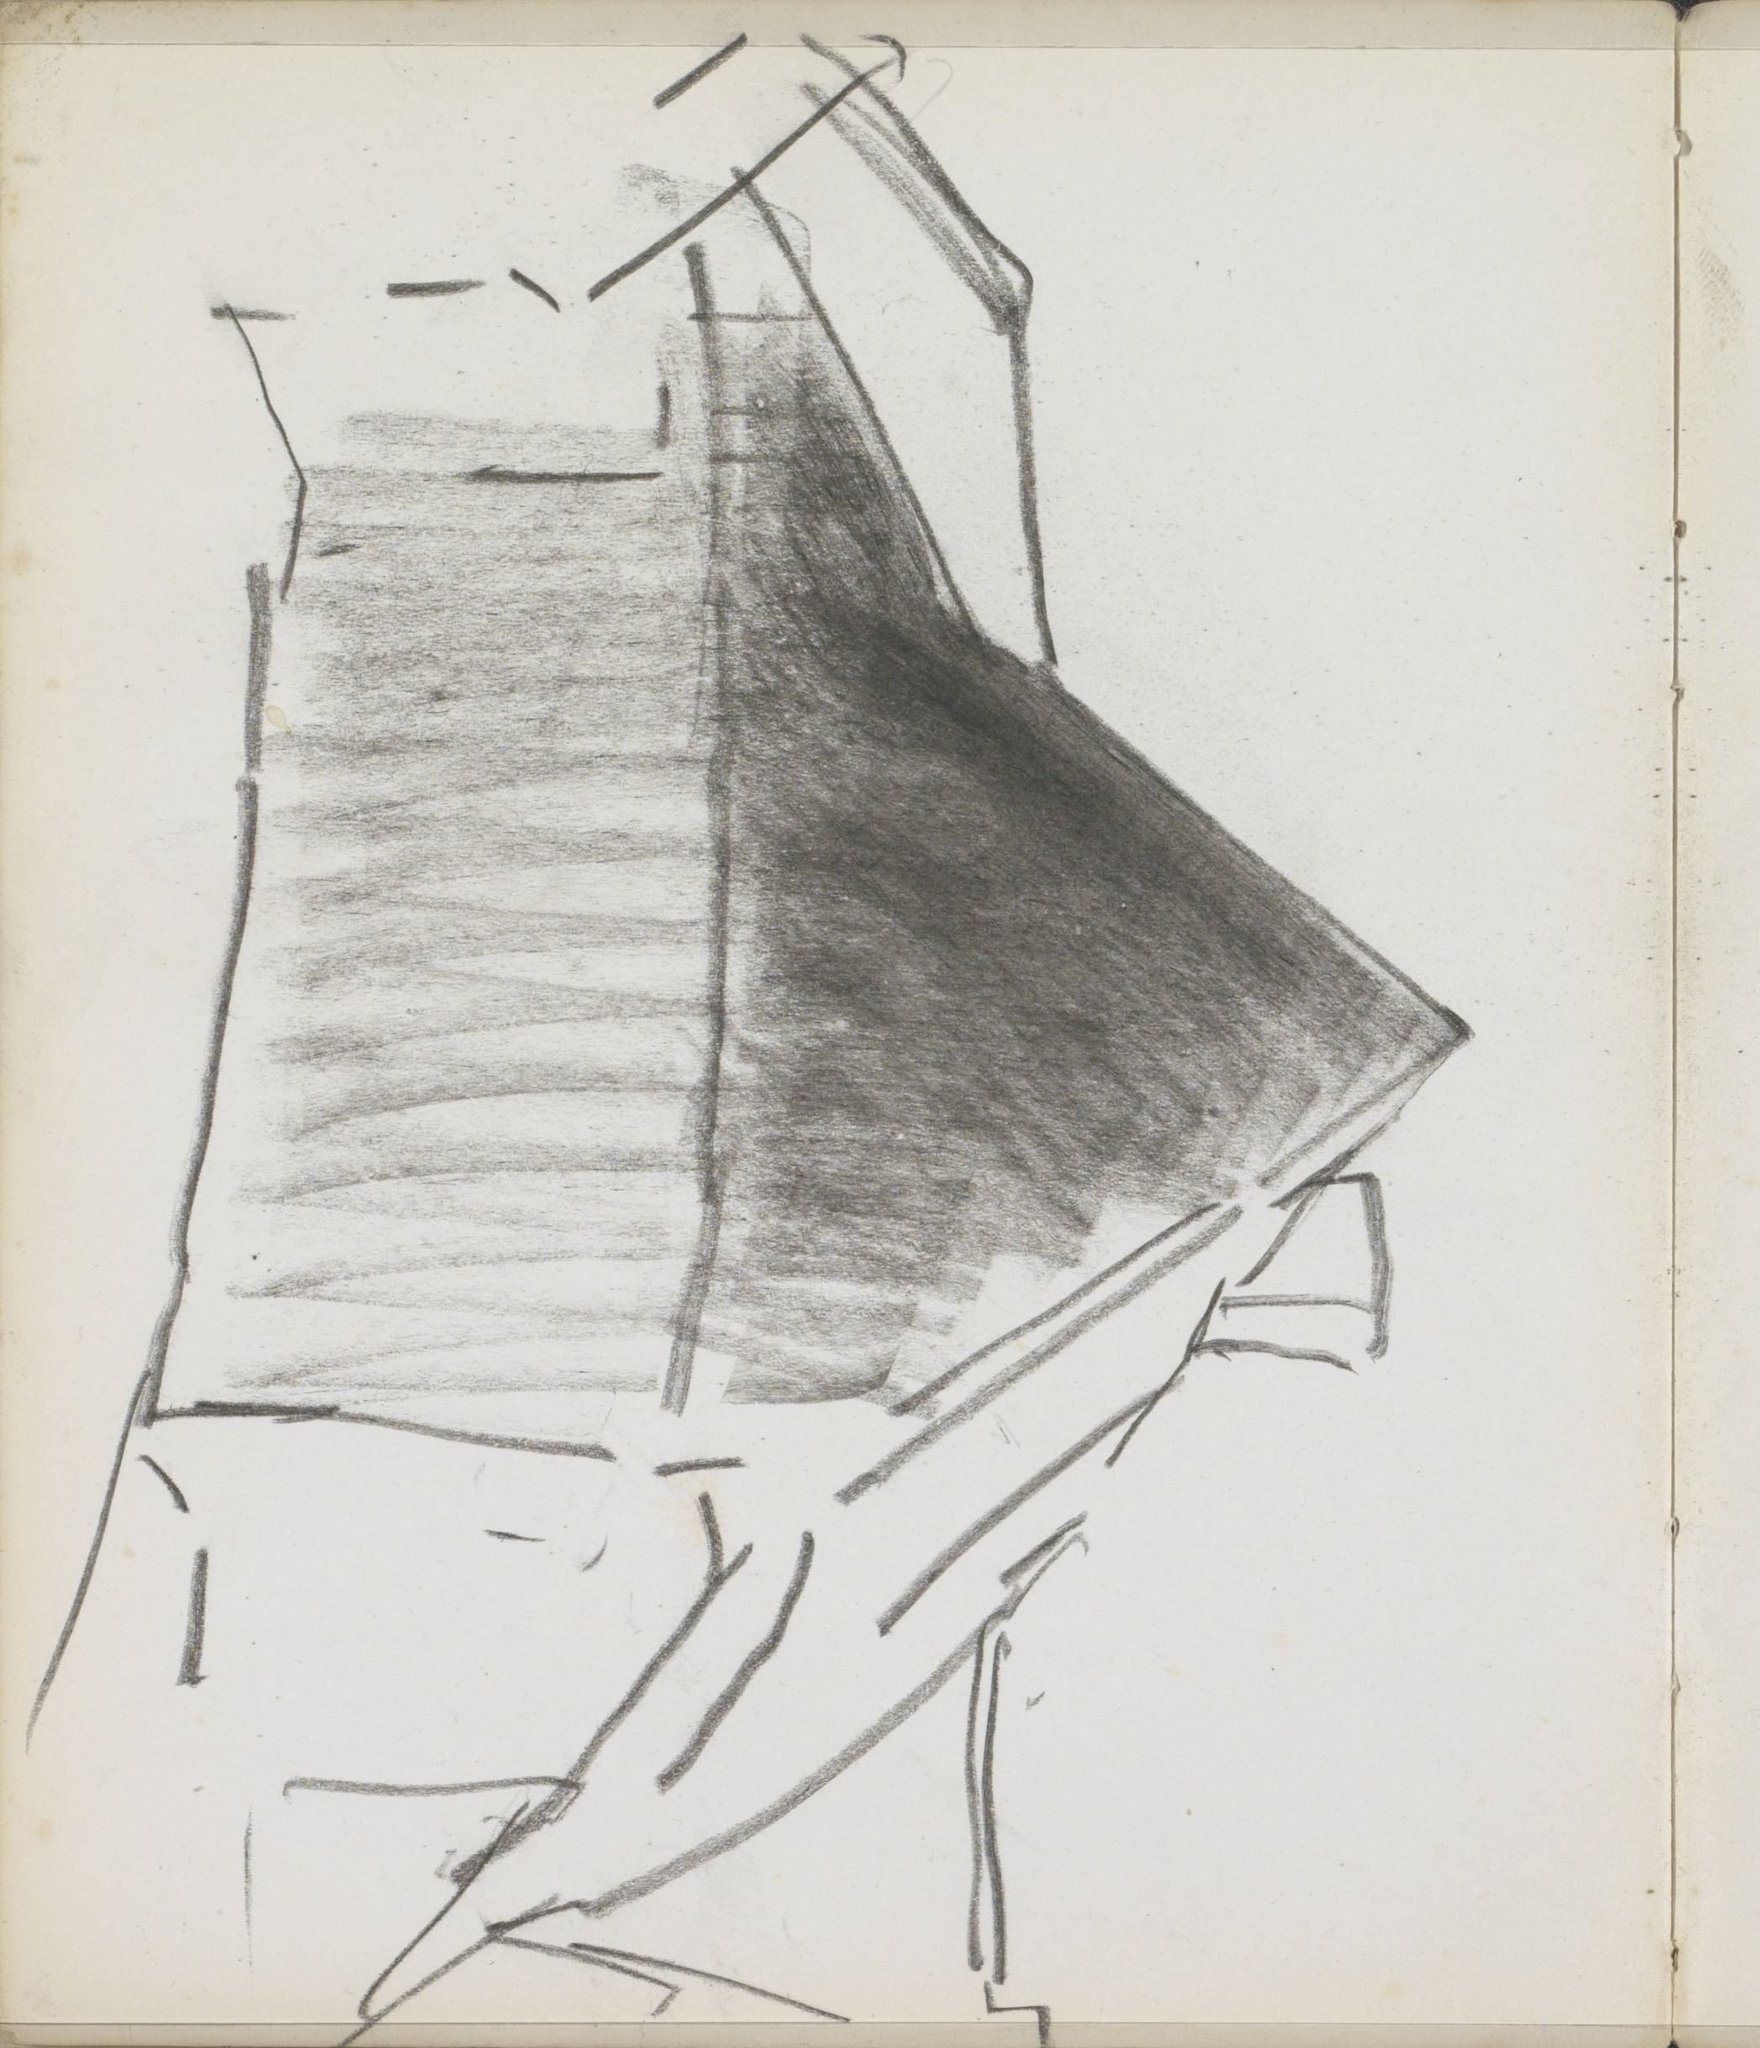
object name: sketchbook leaf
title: Boerderij of schuur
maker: george hendrik breitner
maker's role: draughtsman, painter, print maker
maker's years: 1857-1923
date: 1880-1906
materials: chalk, paper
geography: netherlands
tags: barn, farm (building)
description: Pagina 139 uit een schetsboek met 81 bladen.